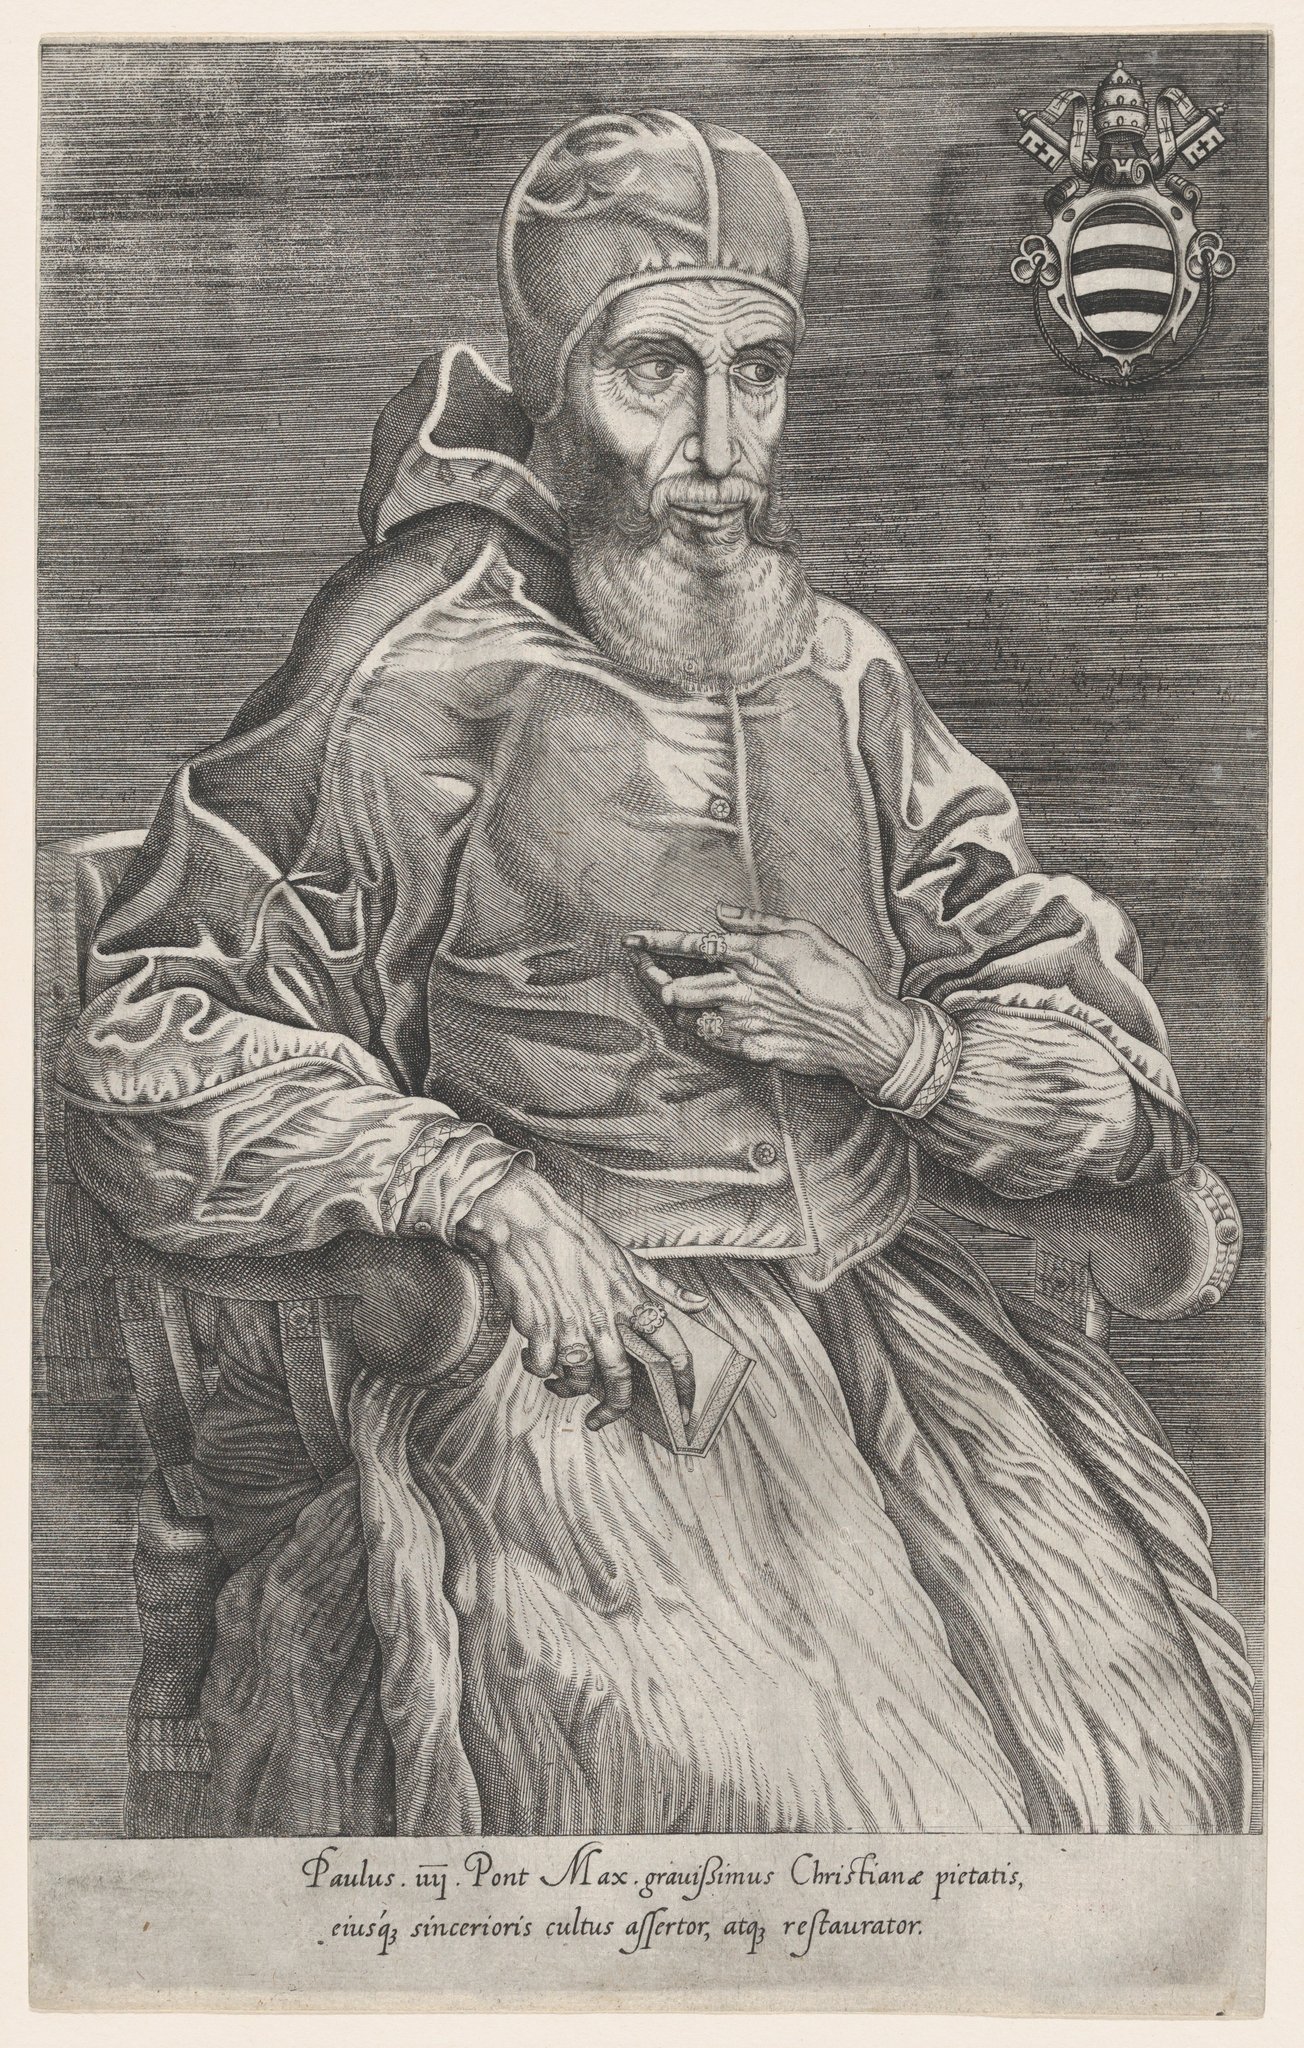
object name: print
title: Portrait of Pope Paulus IV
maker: nicolas beatrizet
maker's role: artist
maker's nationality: french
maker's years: 1515-1566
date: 1530-1566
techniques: engraving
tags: men,popes,coat of arms